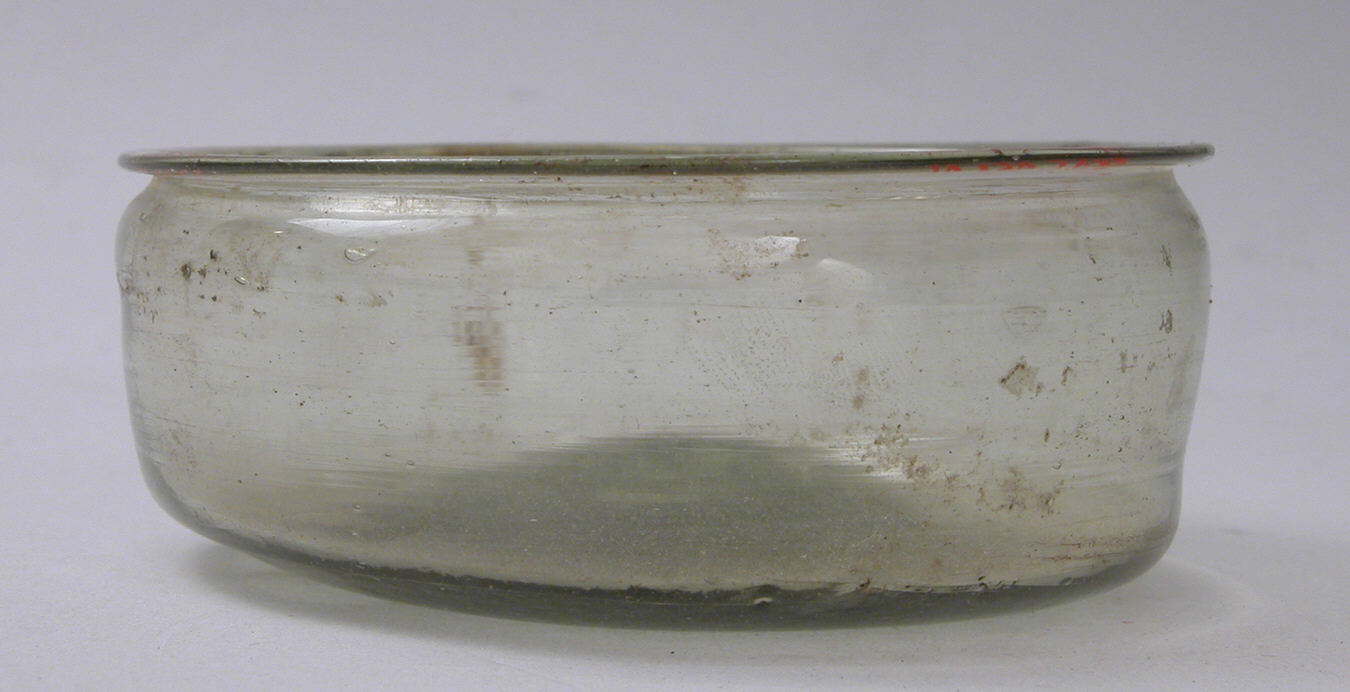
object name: bowl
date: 701-900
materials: glass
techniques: glassblowing, tooling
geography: egypt